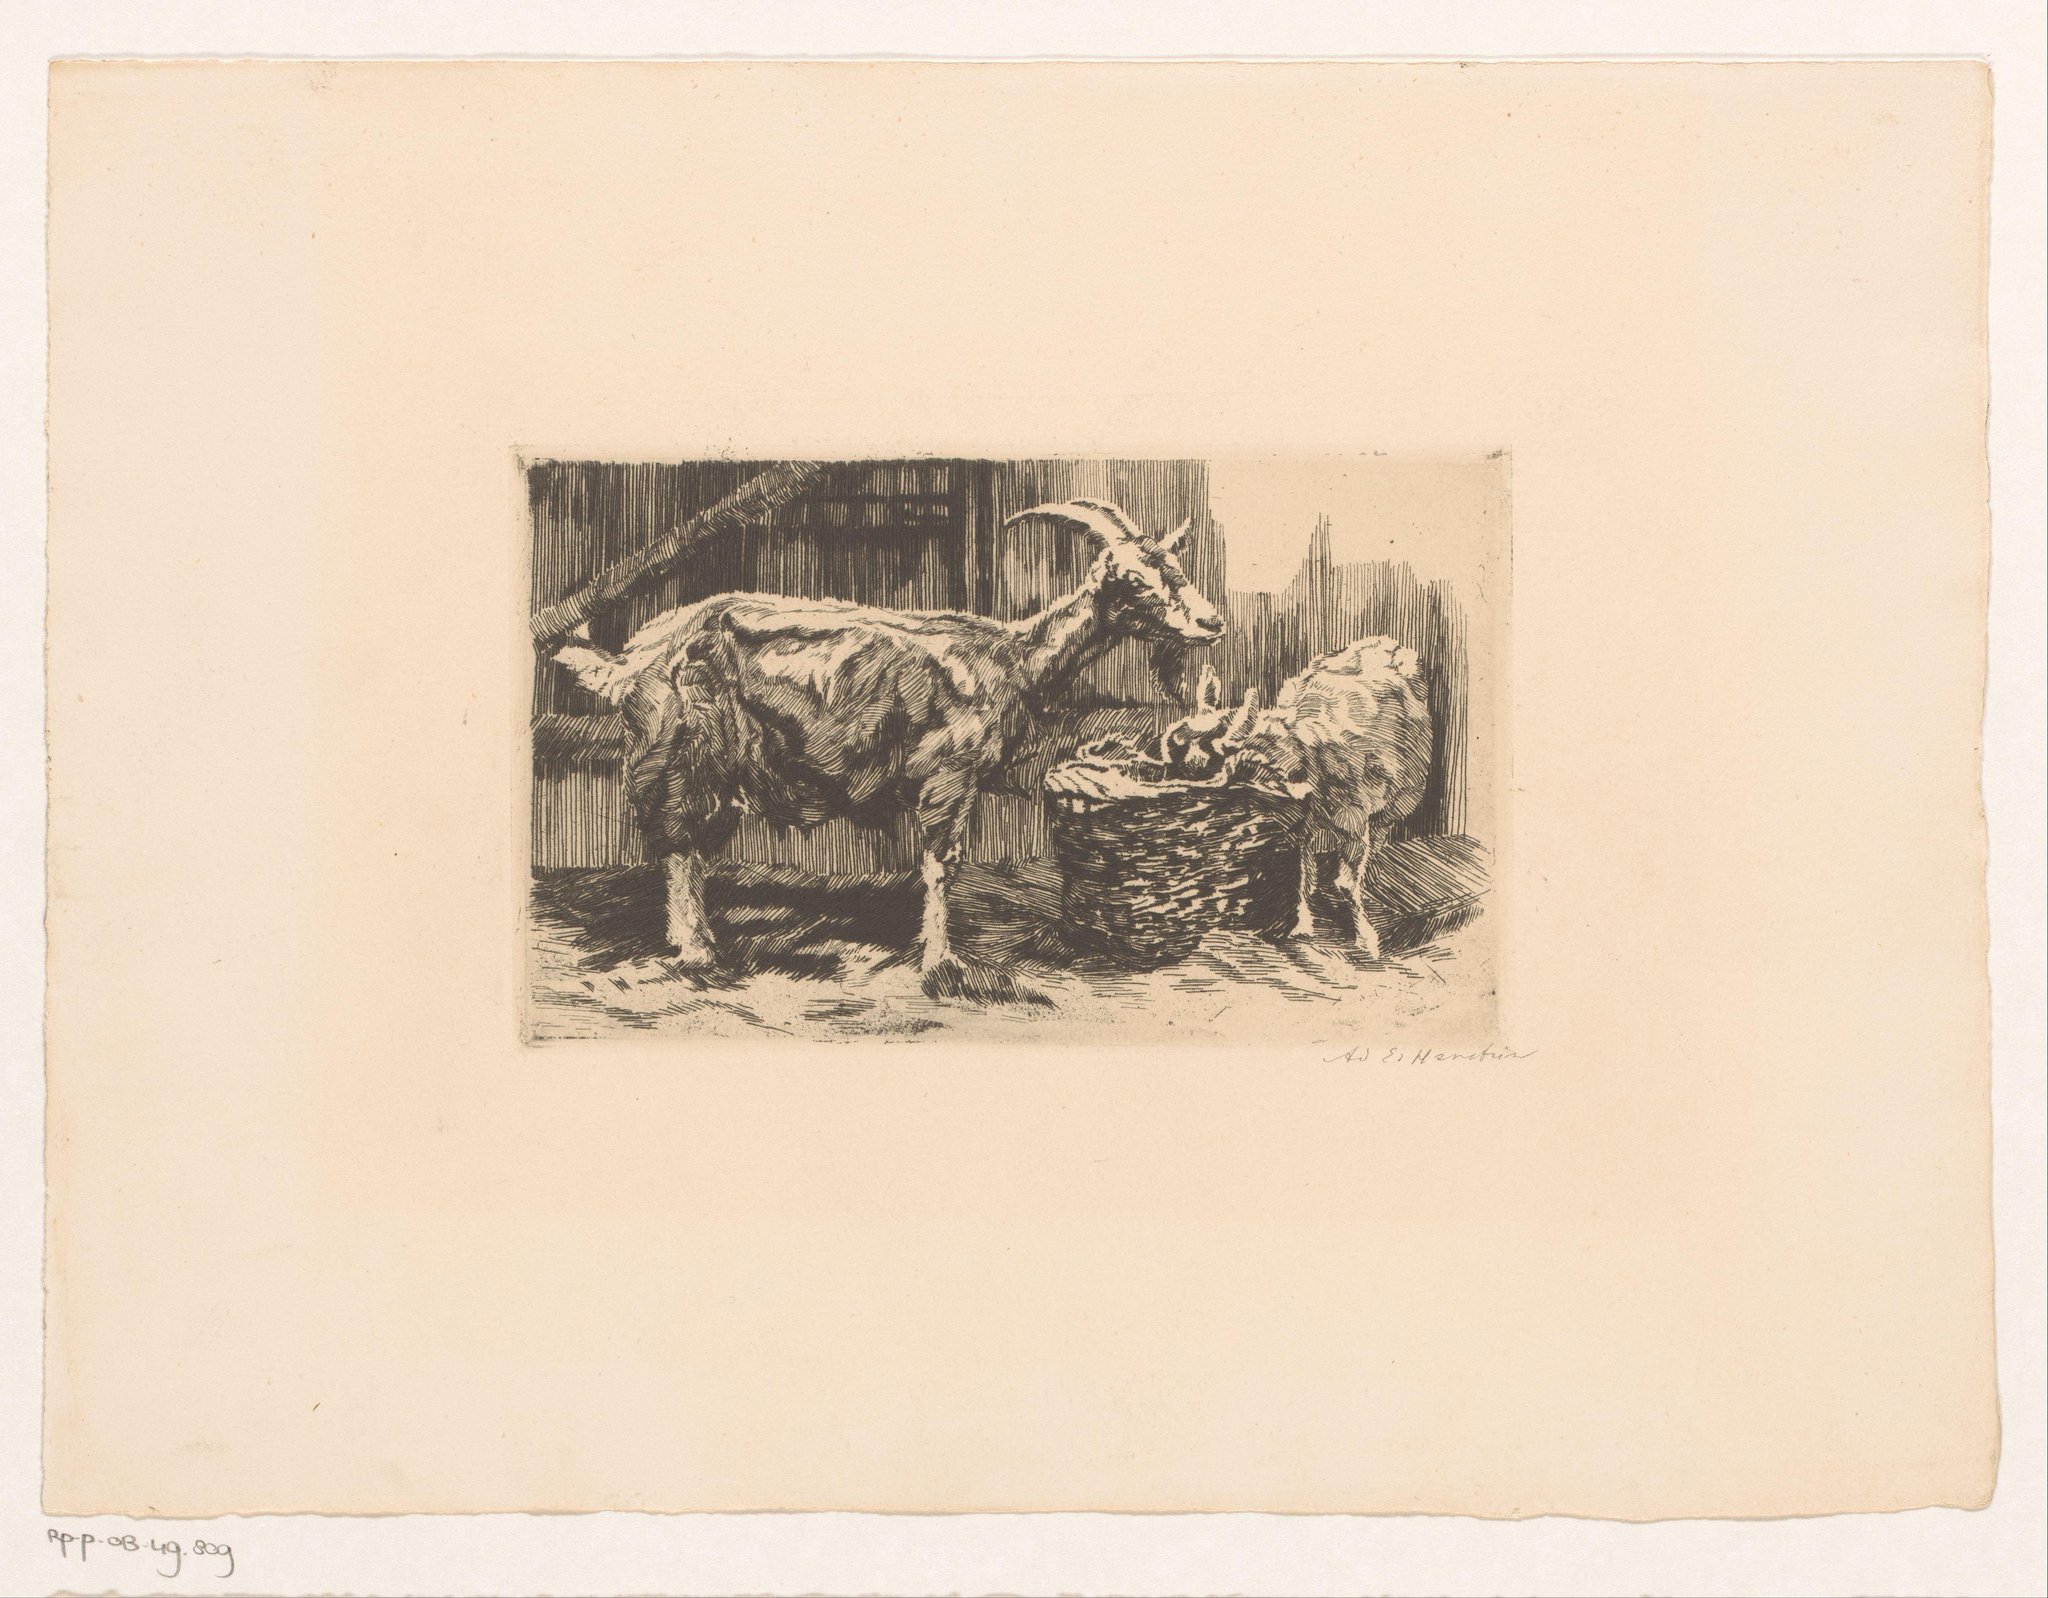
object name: print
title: Bok en geit bij mand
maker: adolf eduard herstein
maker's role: print maker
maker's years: 1869-1932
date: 1879-1932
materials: paper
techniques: drypoint, etching, intaglio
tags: goat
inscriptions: collector's mark: Lugt 2228